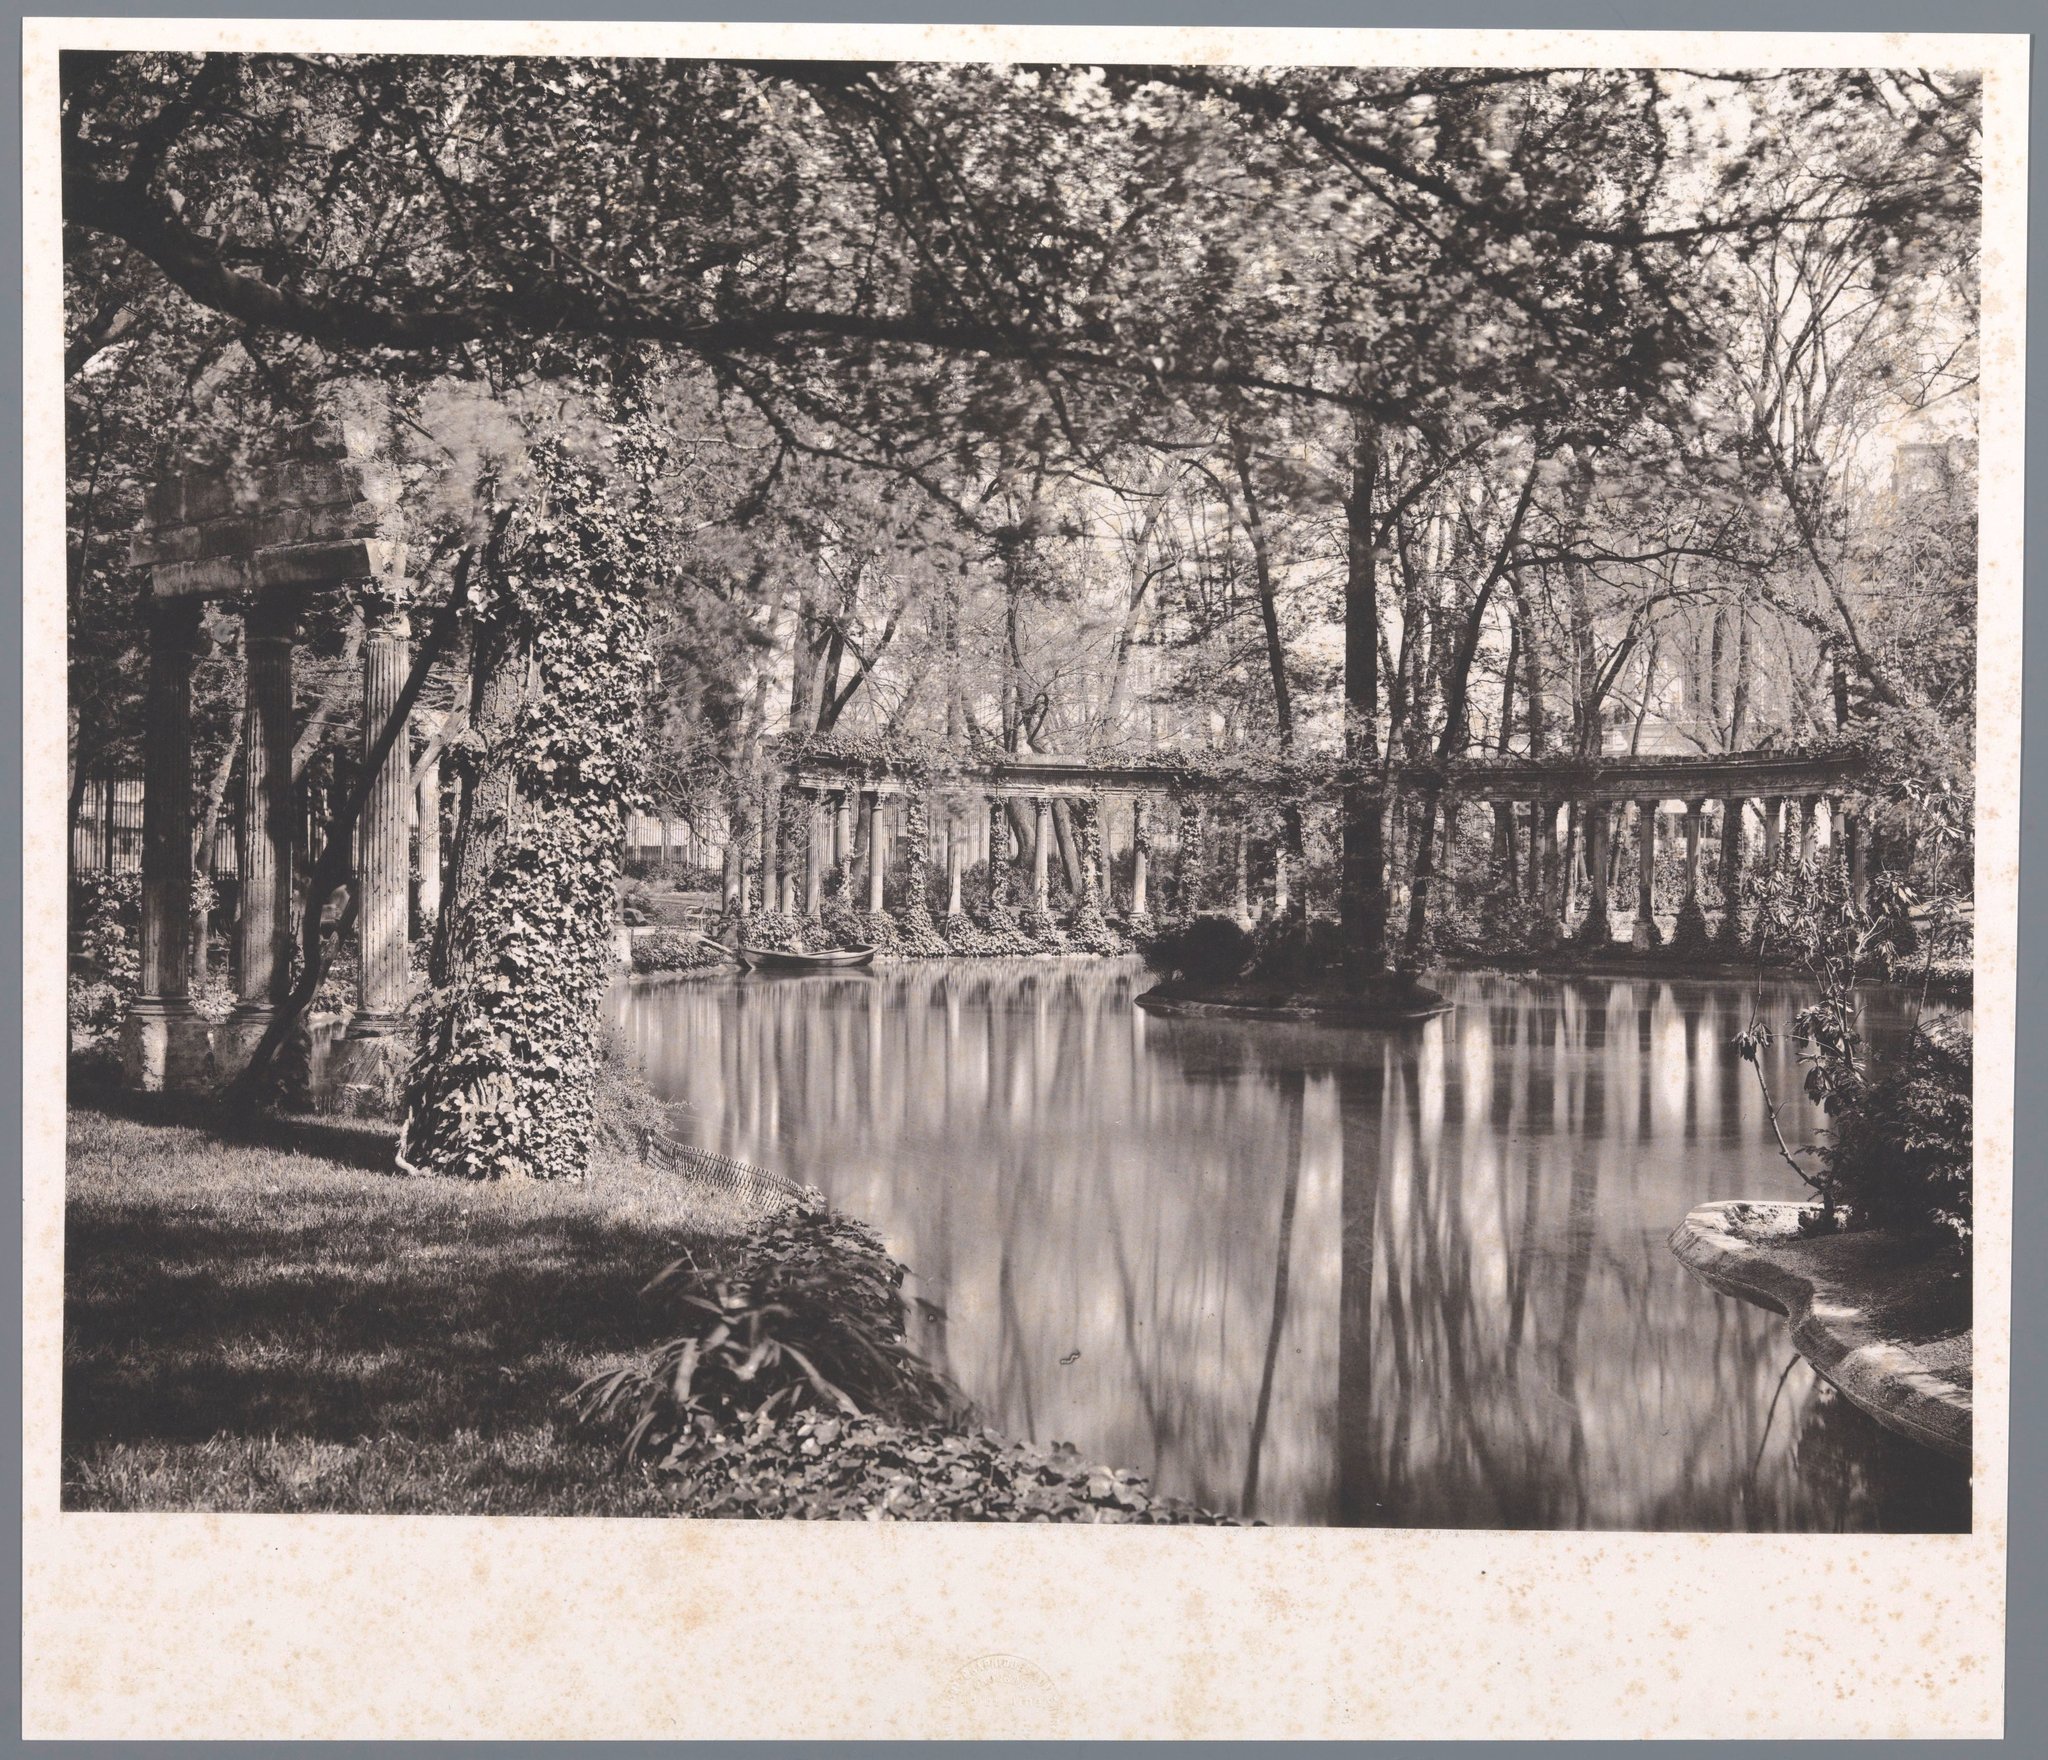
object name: photograph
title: Onbekende locatie in of bij Parijs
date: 1860-1880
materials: paper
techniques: photograph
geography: paris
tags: public gardens, park